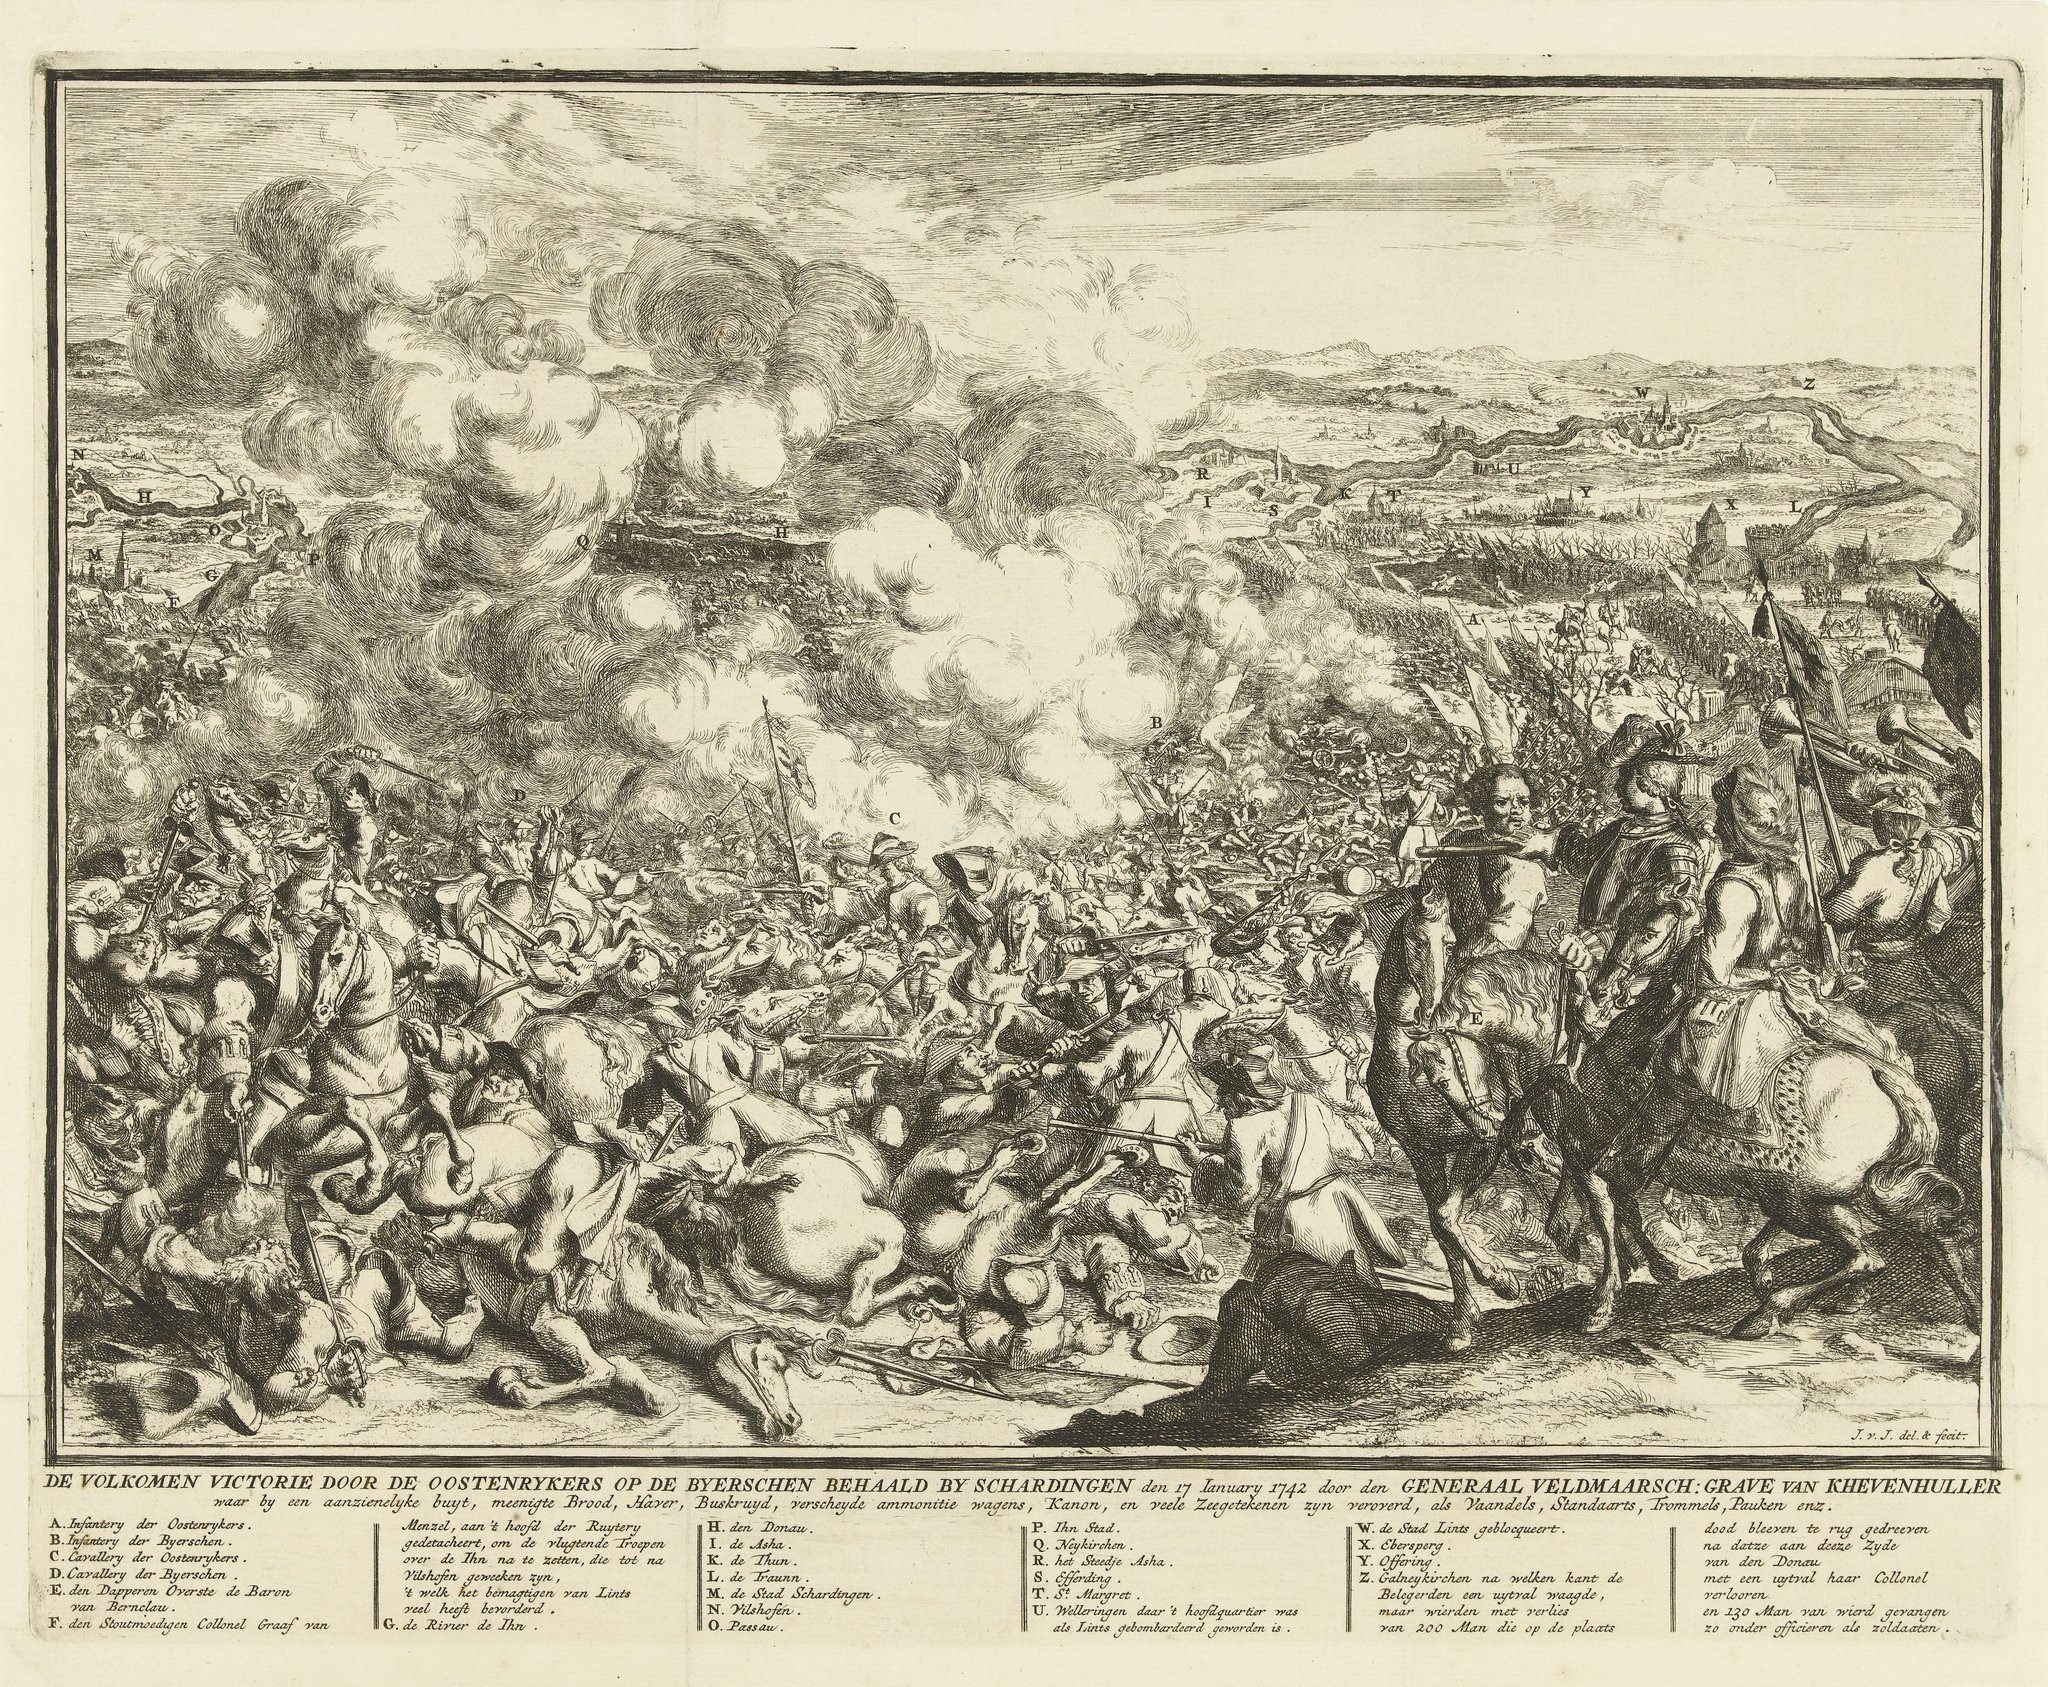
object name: print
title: De volkomen victorie door de Oostenrijkers op de Byerschen behaald by Schardingen den 17 Ianuary 1742 door den Generaal Veldmaarsch: Grave van Khevenhuller (...)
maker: jan van jagen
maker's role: print maker, publisher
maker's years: 1709-1800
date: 1742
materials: paper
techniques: engraving, etching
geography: amsterdam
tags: vienna, ludwig andreas von khevenhüller, battle (+ land forces)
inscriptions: collector's mark: Lugt 2165, collector's mark: Lugt 2760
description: Veldslag bij Schärding (Schardingen) in Oostenrijk waar de Oostenrijkse generaal Ludwig Andreas von Khevenhüller op 17 januari 1742 een overwinning behaalt op de Fransen en Beiersen. Rechts op de voorgrond de Oostenrijkse bevelhebbers te paard het gevecht overziende. In het onderschrift de legenda A-Z.